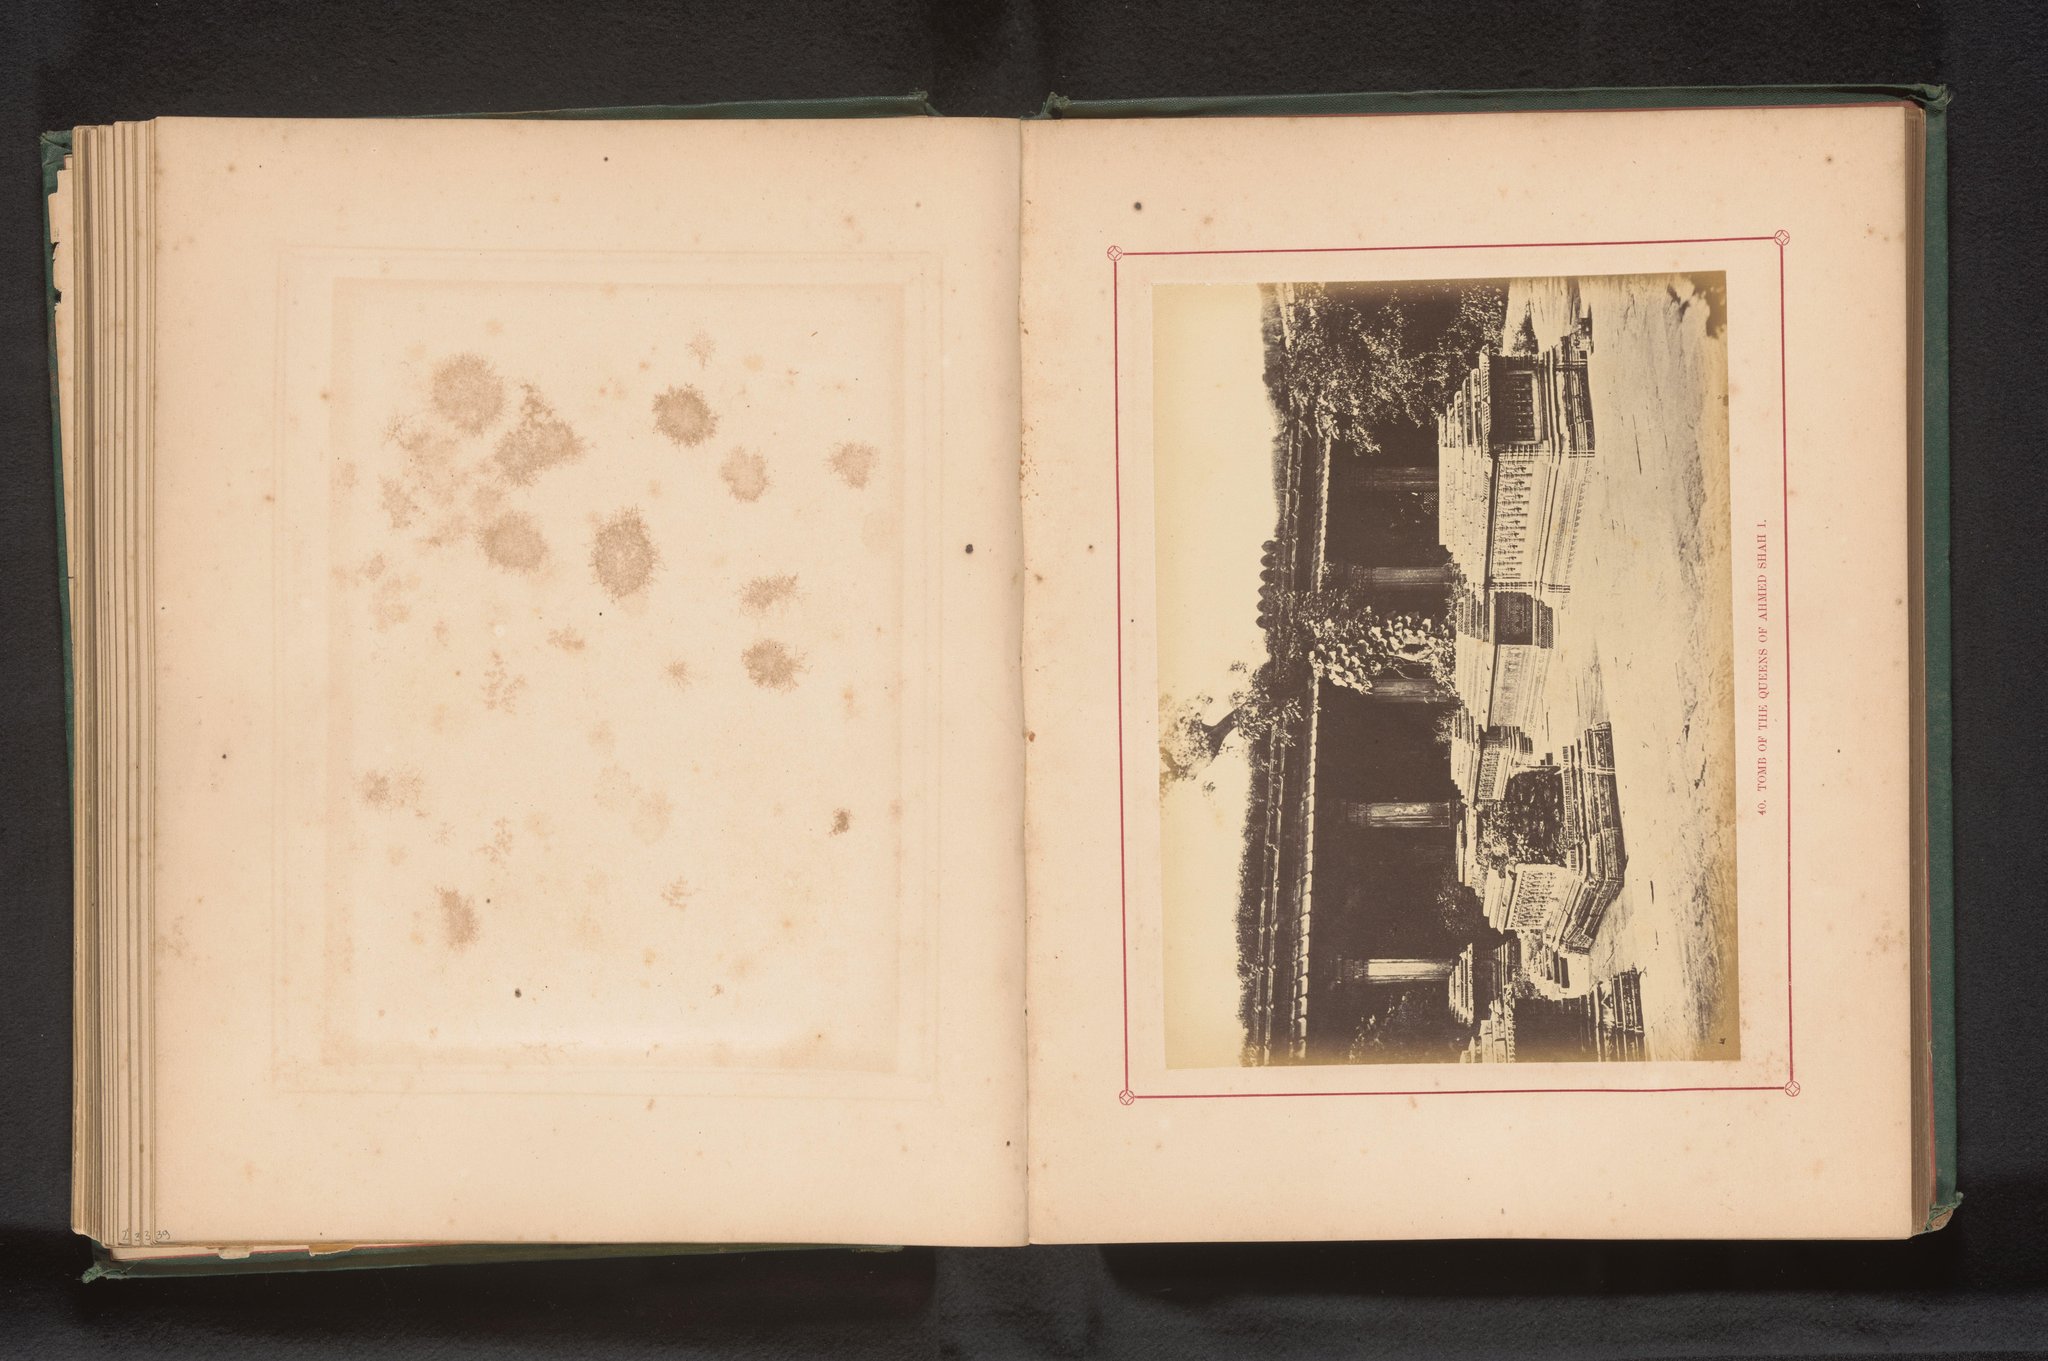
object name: page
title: Tombes op Rani no Hajiro in Ahmedabad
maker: thomas biggs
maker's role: fotograaf, kapitein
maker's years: 1822-1905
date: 1856-1866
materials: photographic support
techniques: albumen print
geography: ahmedabad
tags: grave, tomb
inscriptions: number: ‘40.’